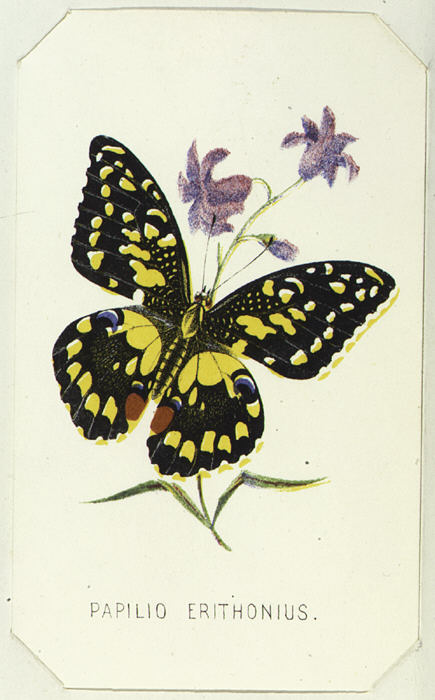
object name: album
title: American Card Album, containing sets of collectors cards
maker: louis prang & co.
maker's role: publisher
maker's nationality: american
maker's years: 1800-1950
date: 1864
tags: butterflies